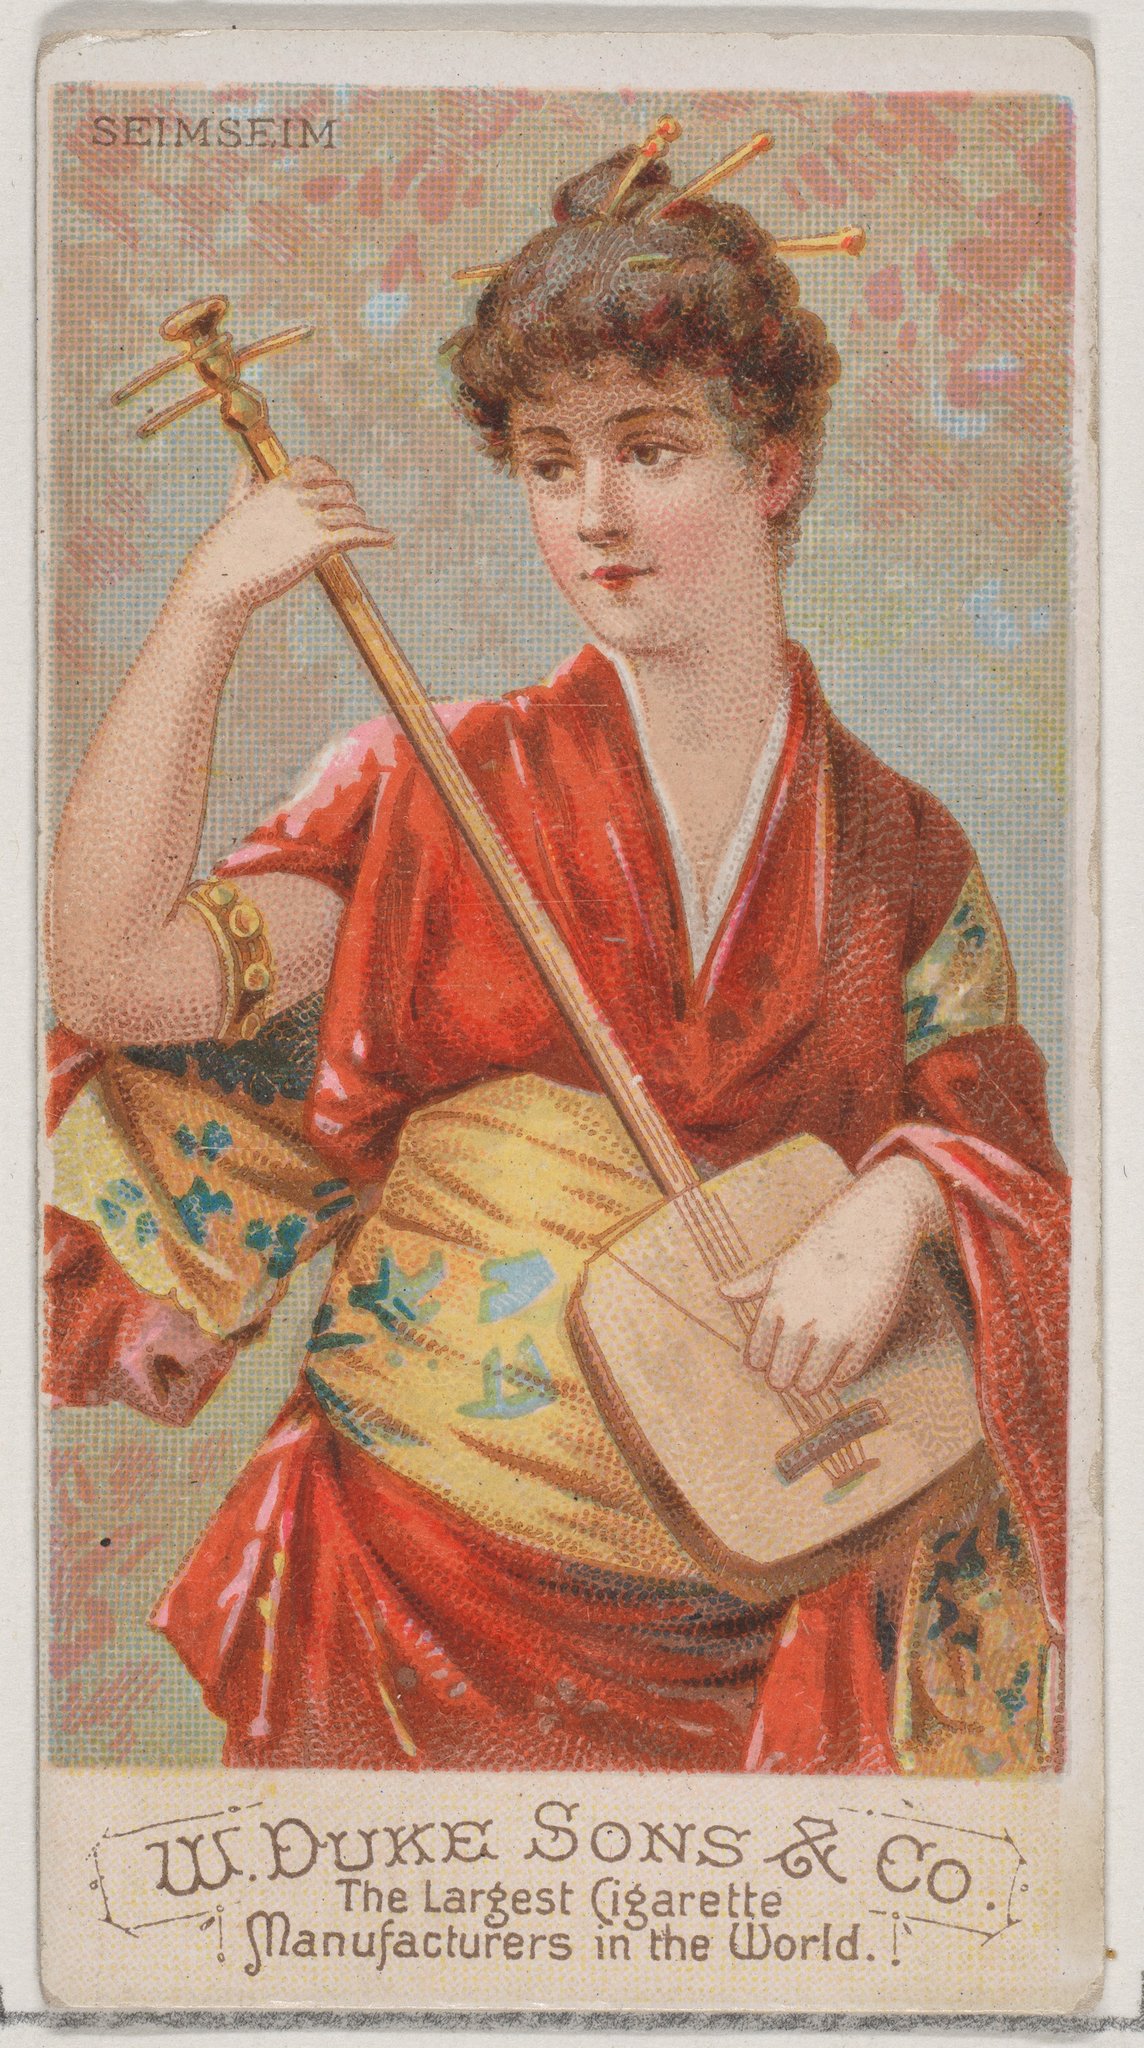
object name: print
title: Seimseim, from the Musical Instruments series (N82) for Duke brand cigarettes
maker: w. duke, sons & co.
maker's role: publisher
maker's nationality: american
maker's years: 1870-1920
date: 1888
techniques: color lithograph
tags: musical instruments,women,musicians